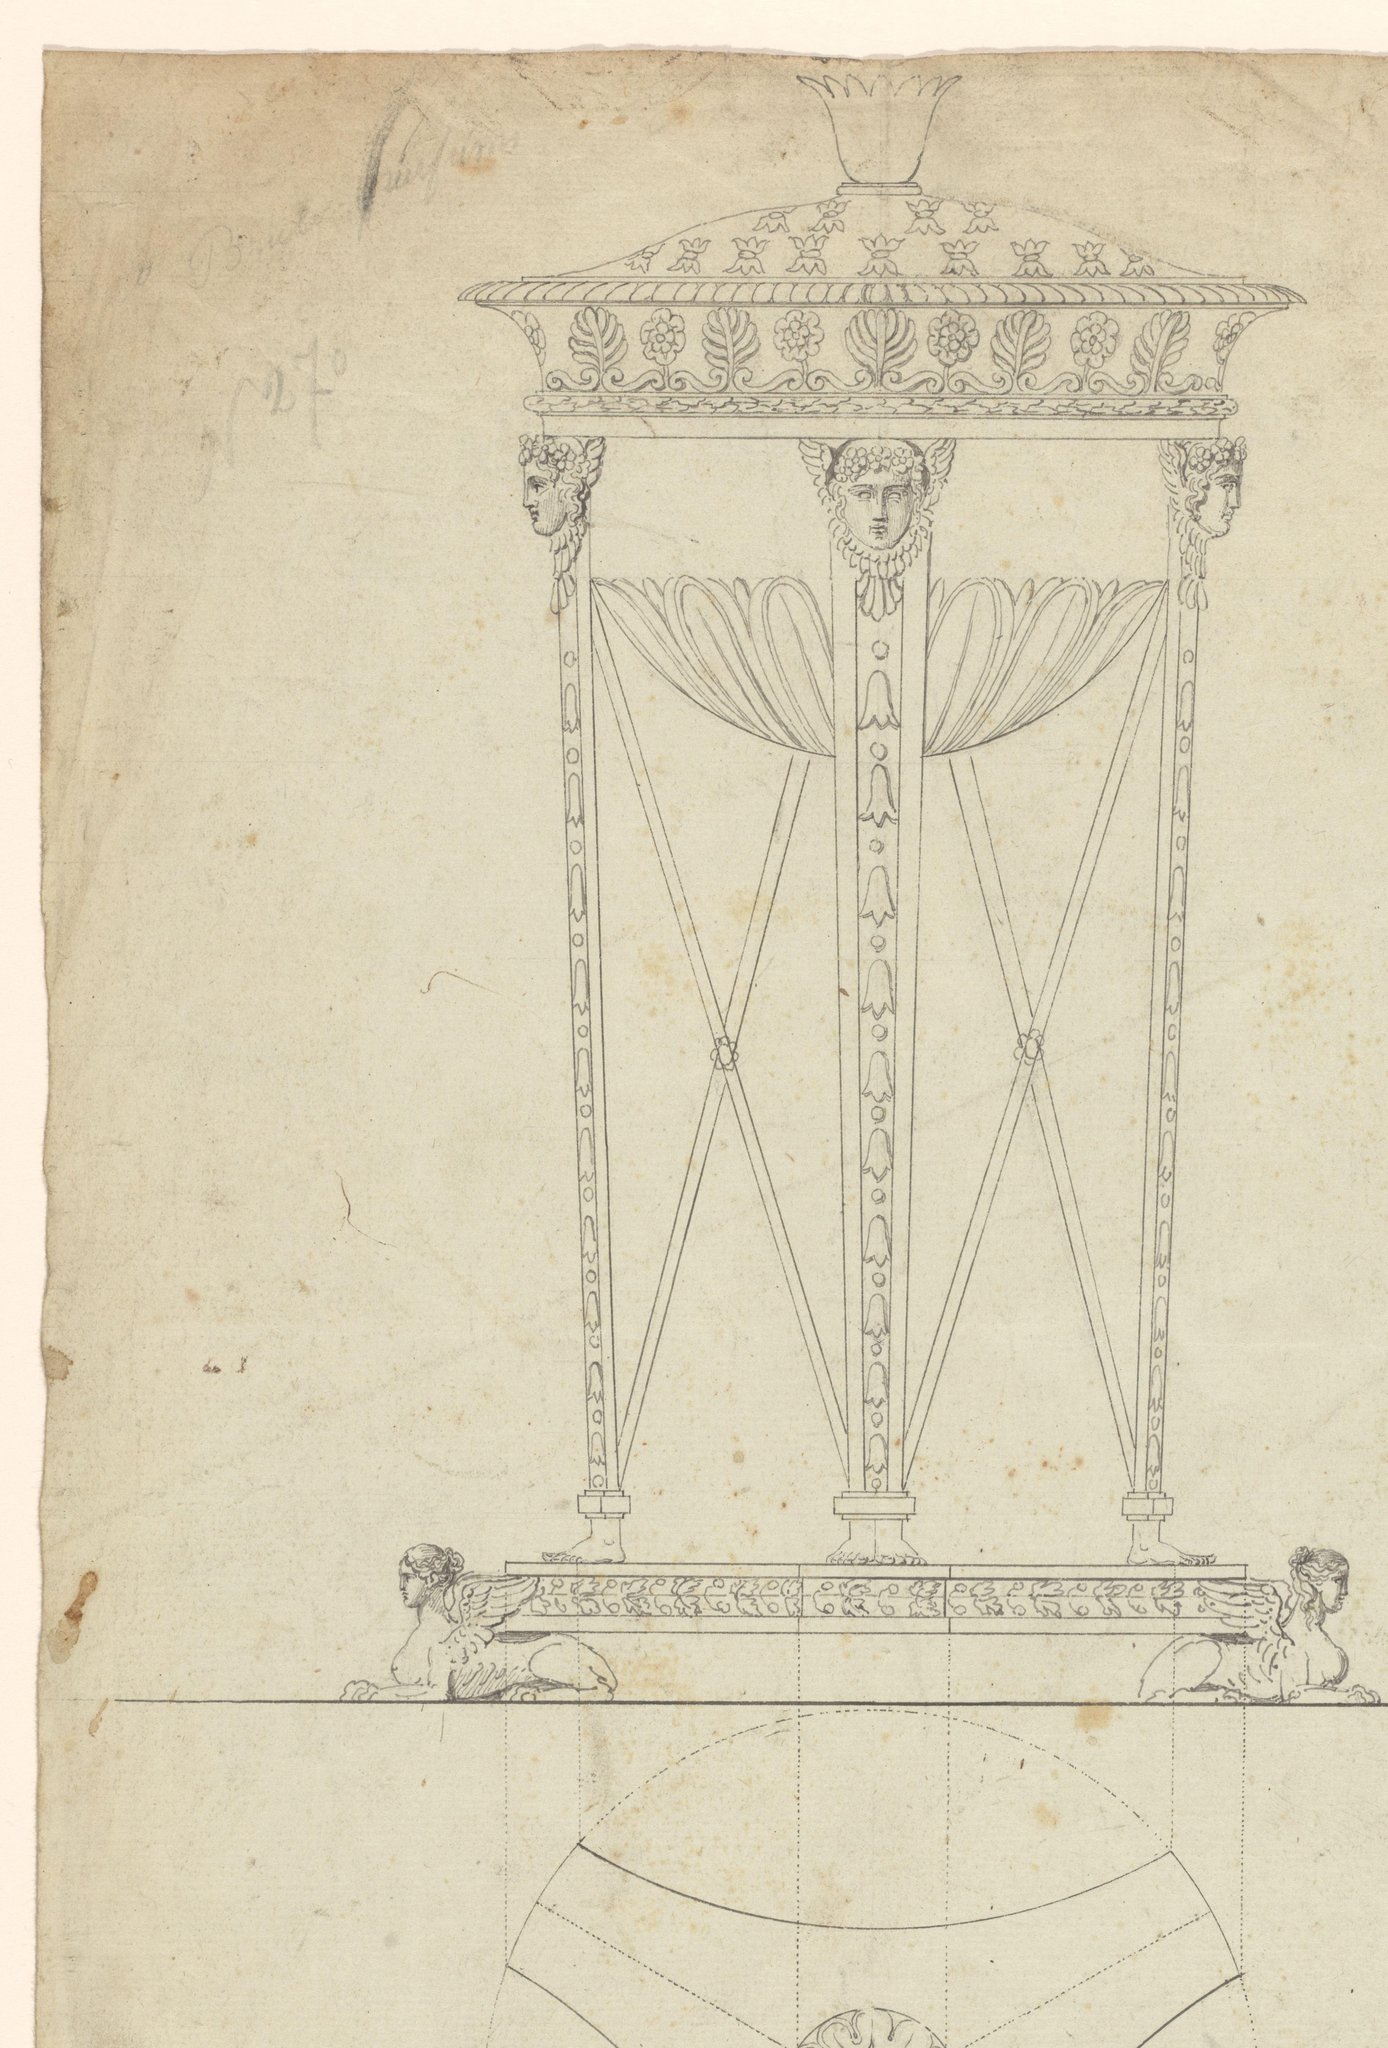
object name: design drawing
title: Ontwerp voor een cassolette, met daaronder een bovenaanzicht van de bodem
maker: Anonymous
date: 1800-1810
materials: ink, paper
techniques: pen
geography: paris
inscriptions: watermark, number: ‘No 270’